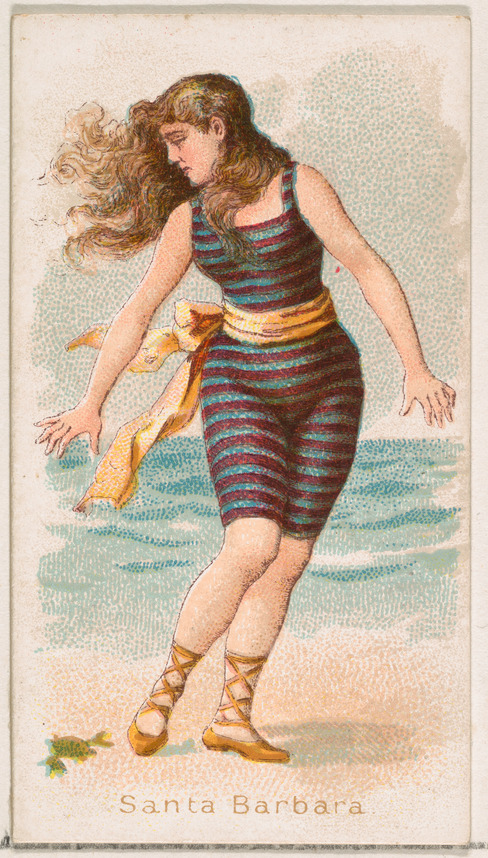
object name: print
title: Santa Barbara, from the Fancy Bathers series (N187) issued by Wm. S. Kimball & Co.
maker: william s. kimball & company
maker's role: publisher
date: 1889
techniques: color lithograph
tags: profiles,women